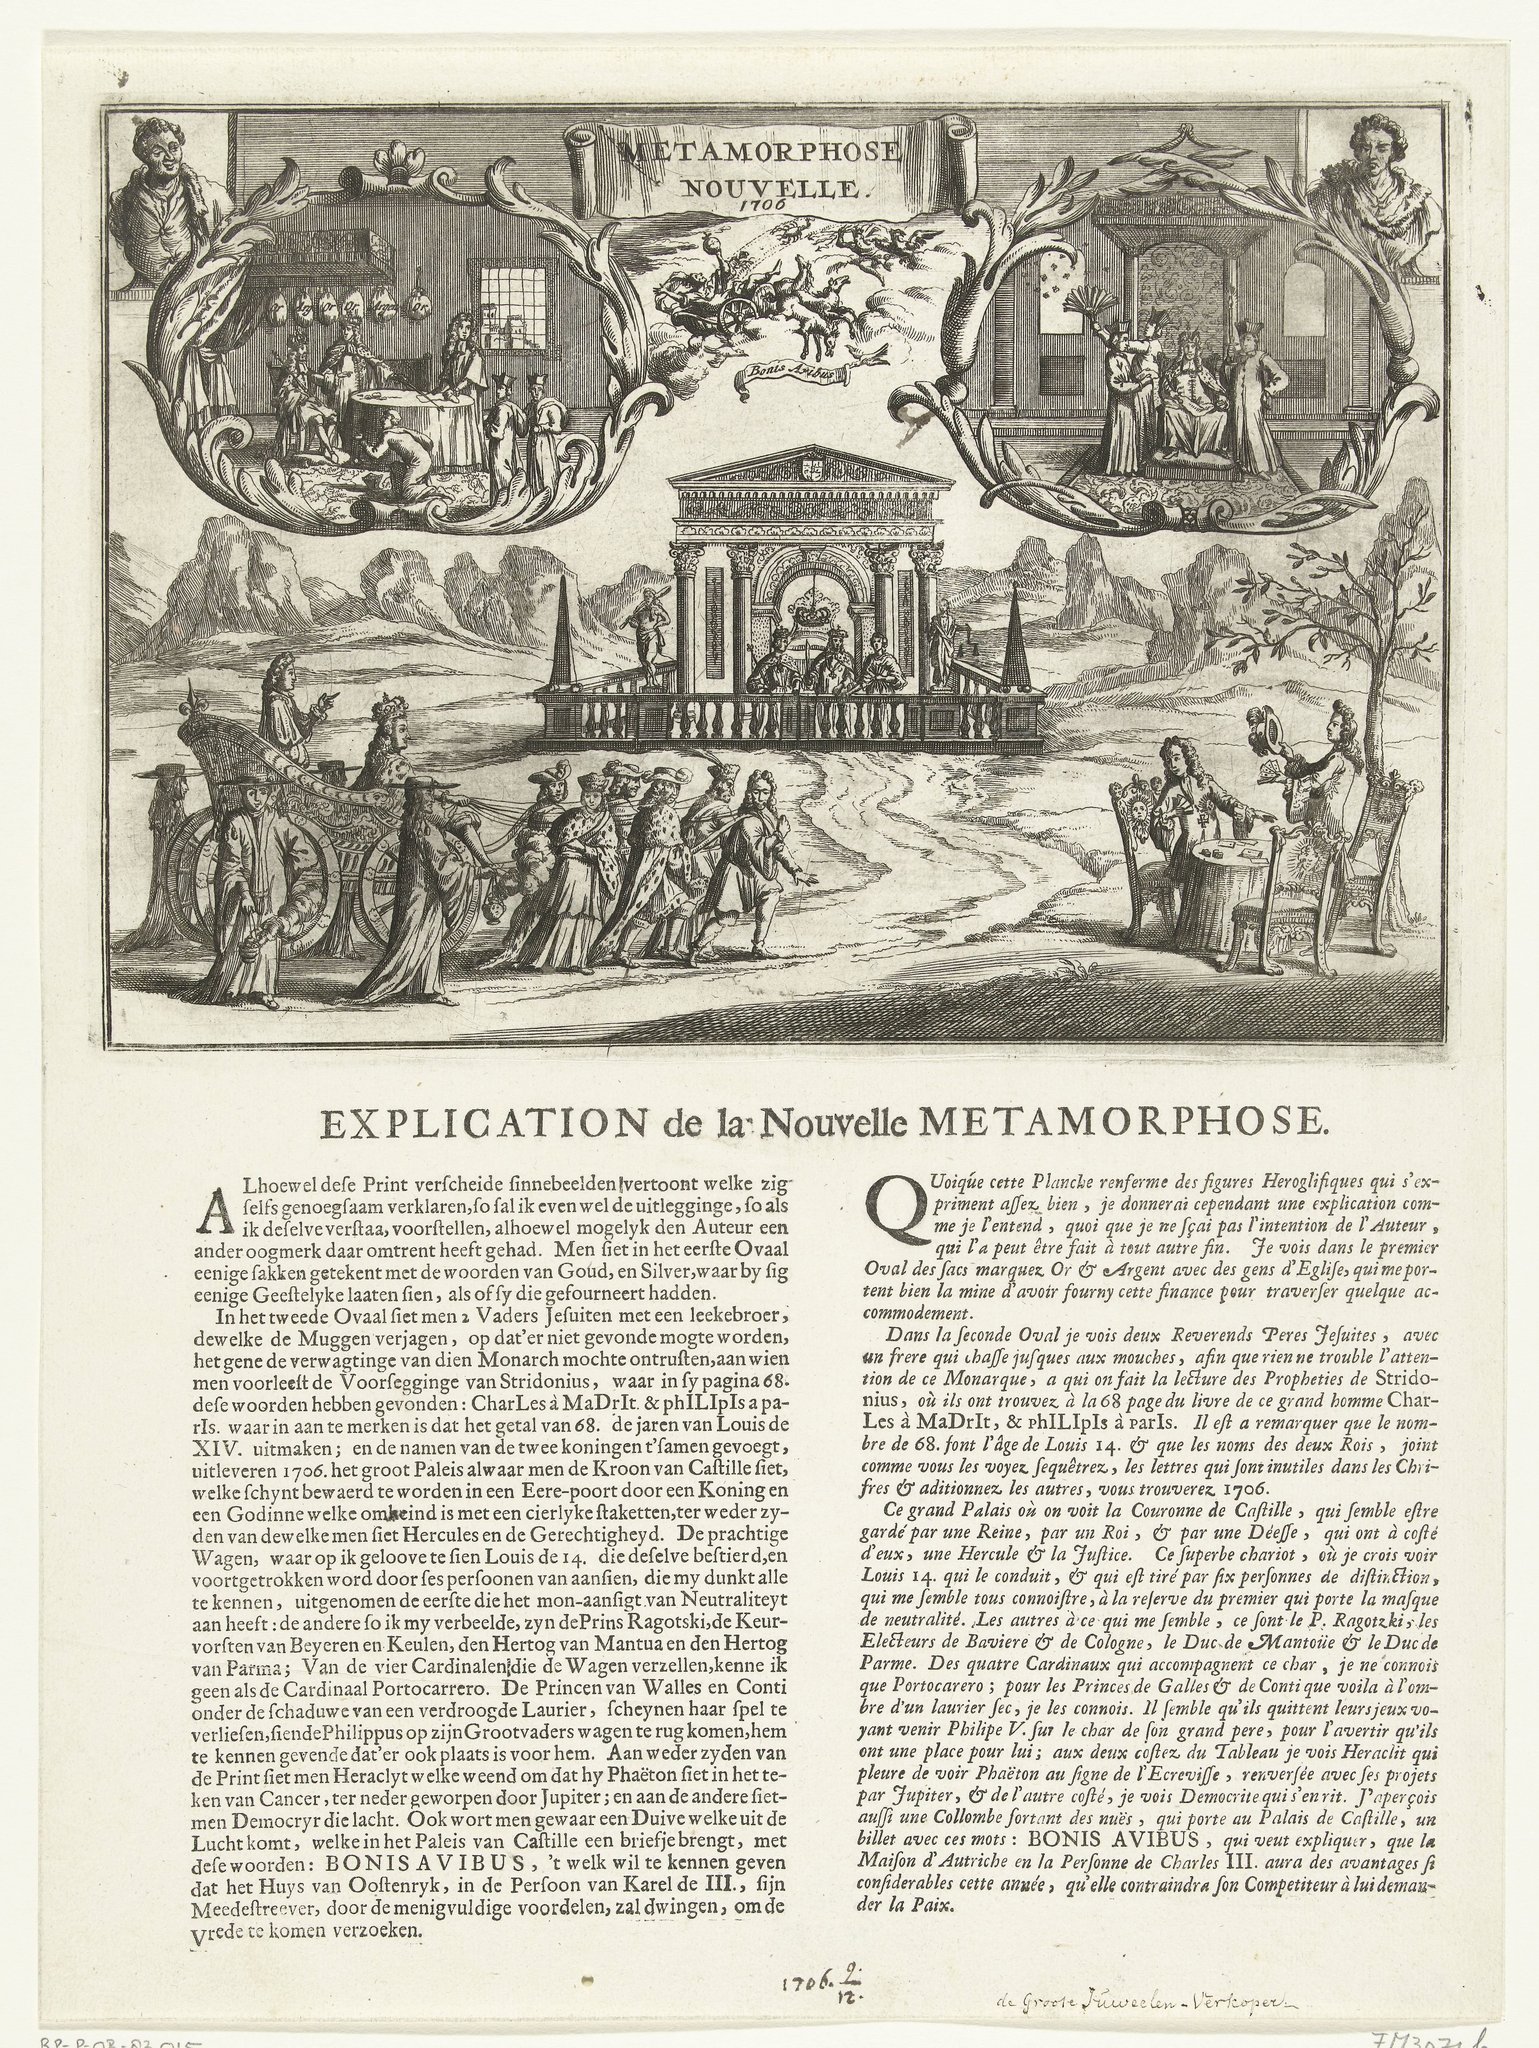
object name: cartoon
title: Koninklijke Almanach van 1701 / 't Lusthof van Momus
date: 1706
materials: paper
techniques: engraving, etching, letterpress printing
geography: amsterdam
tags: lodewijk xiv (koning van frankrijk), filips v (koning van spanje), political caricatures and satires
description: Triomfwagen met Lodewijk XIV en de hertog van Anjou door zes vorsten getrokken in de richting van een tempel waar de Spaanse kroon bewaard wordt. Bovenaan twee cartouches met voorstellingen met jezuïeten, 1706. Op het blad onder de plaat een verklaring in het Nederlands en Frans. Onderaan de notitie: 1706. 9/12. de Groote Juweelen-Verkoper. Onderdeel van een reeks van 19 spotprenten op de Fransen en bondgenoten uit het jaar 1706.